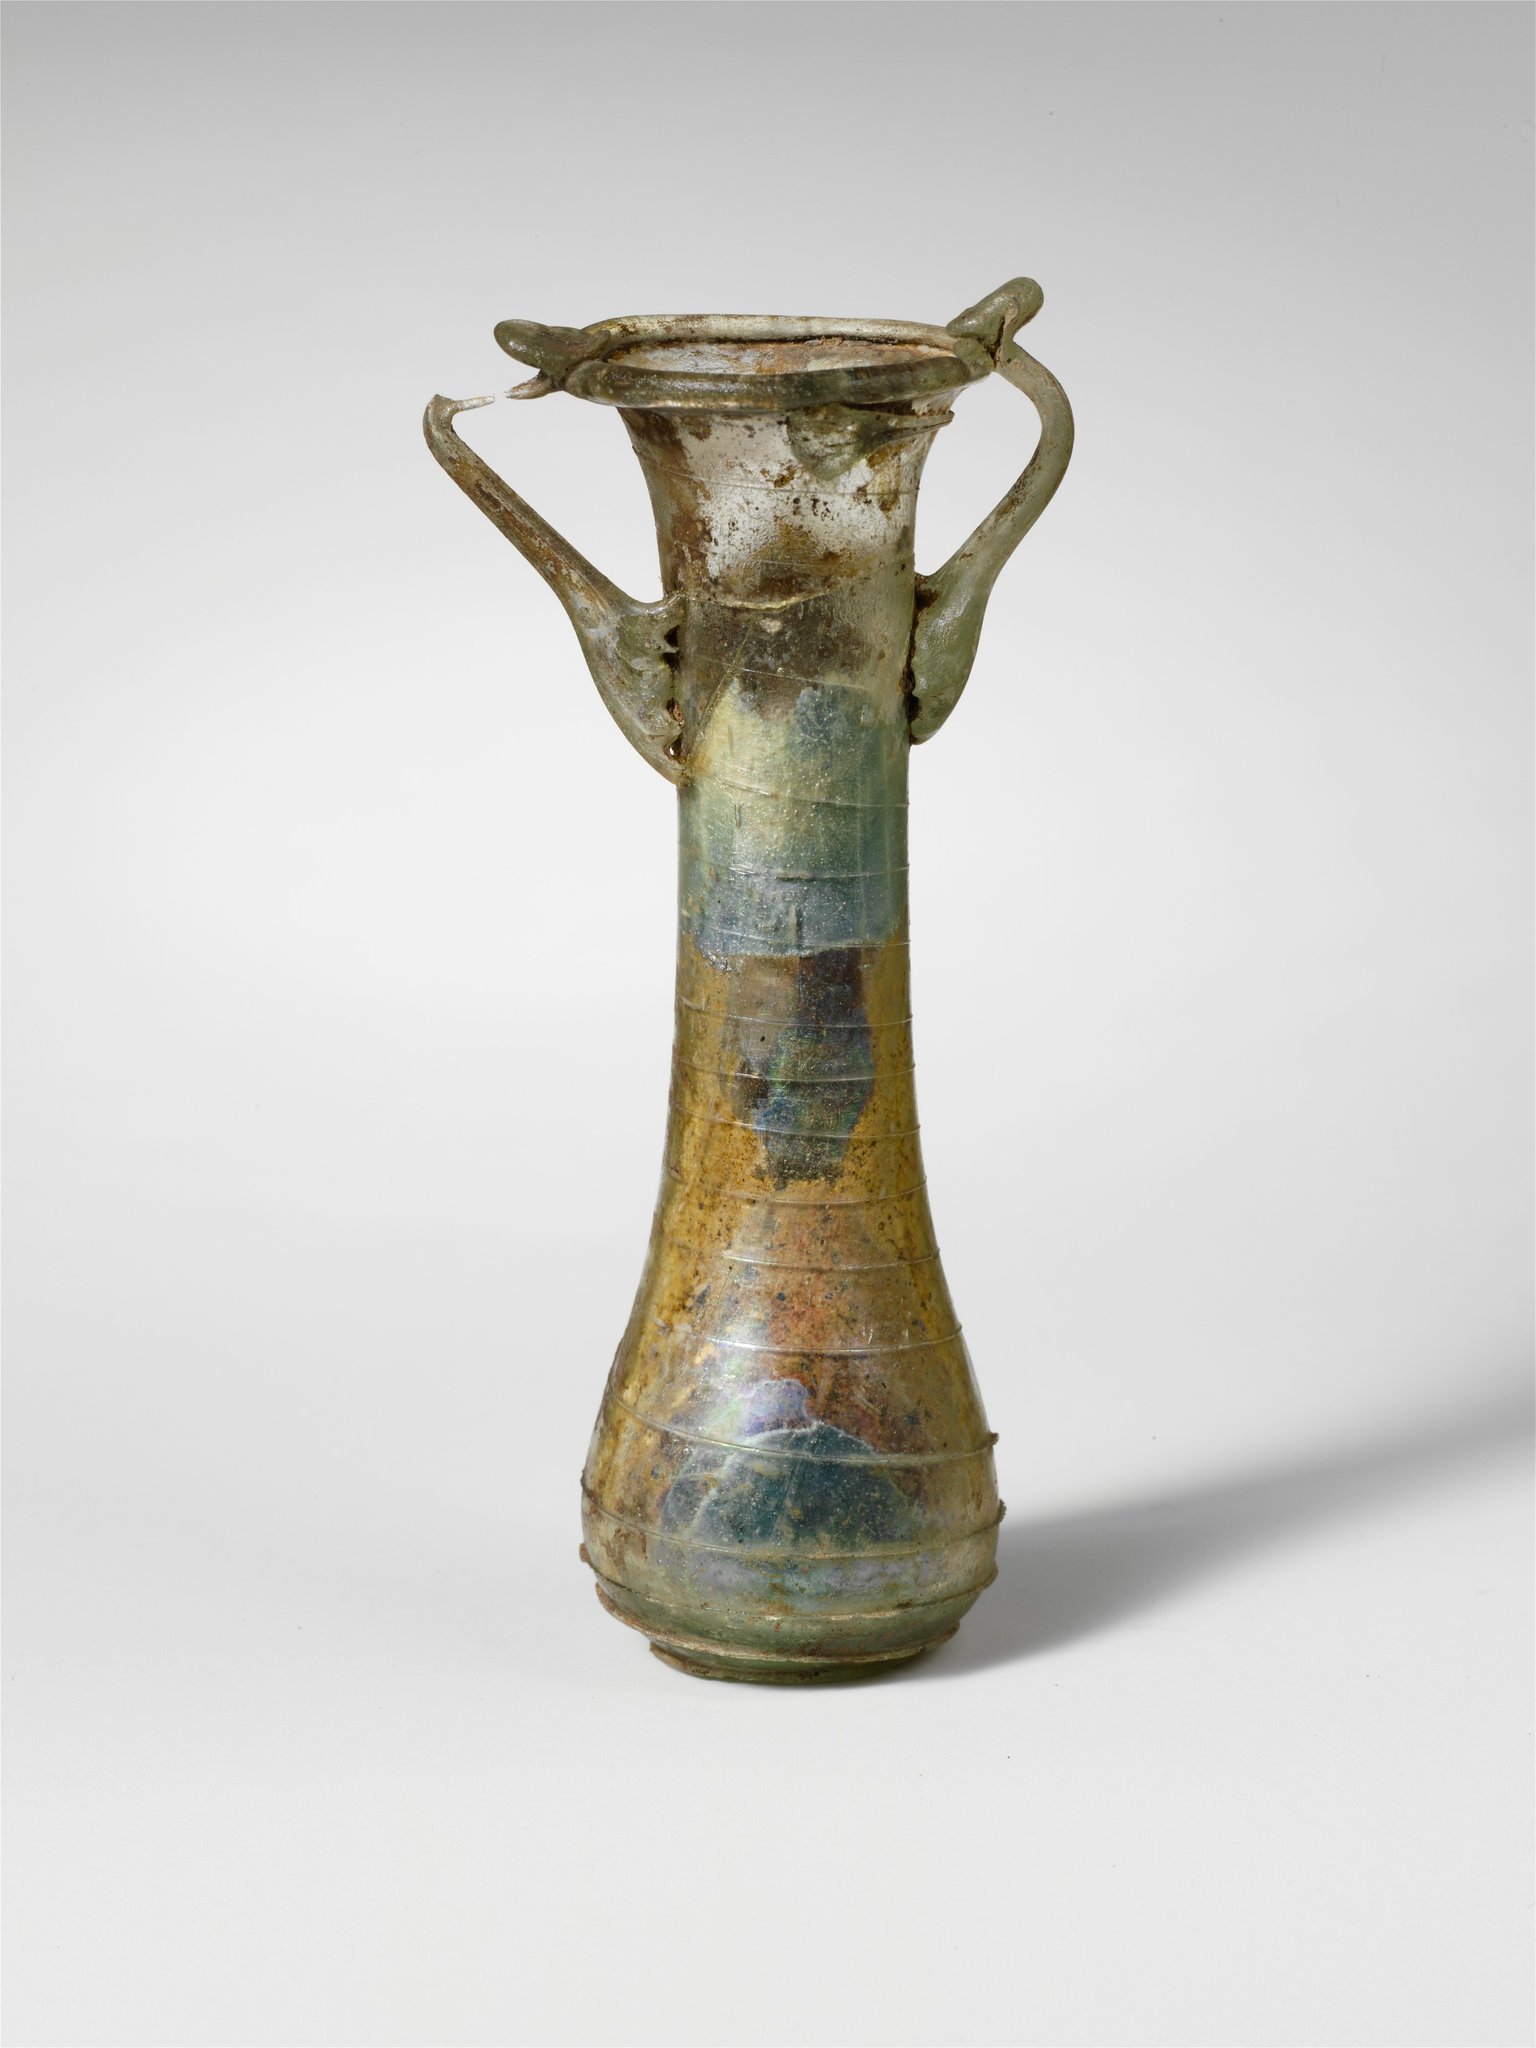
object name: cosmetic flask, single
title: Glass cosmetic flask (kohl tube)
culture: roman, syrian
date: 301-400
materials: glass